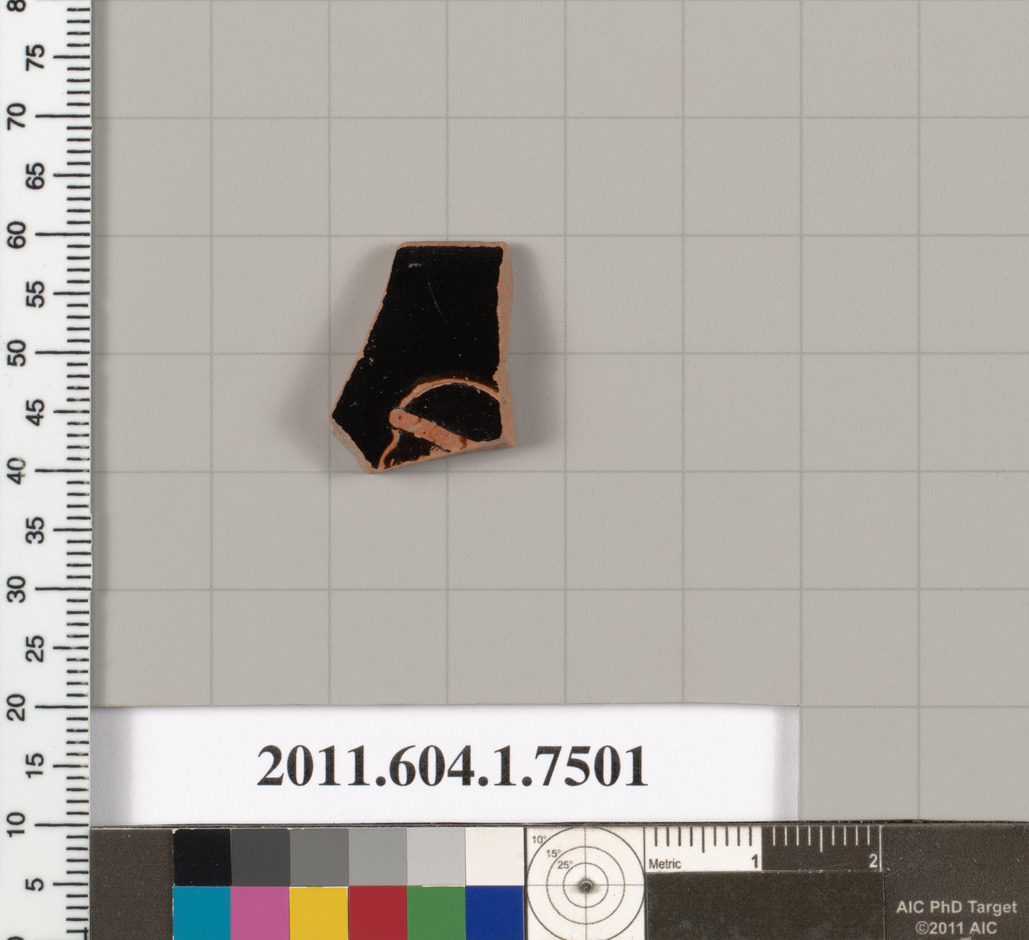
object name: kylix fragment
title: Terracotta rim fragment of a kylix (drinking cup)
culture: greek, attic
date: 460-450 BCE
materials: terracotta